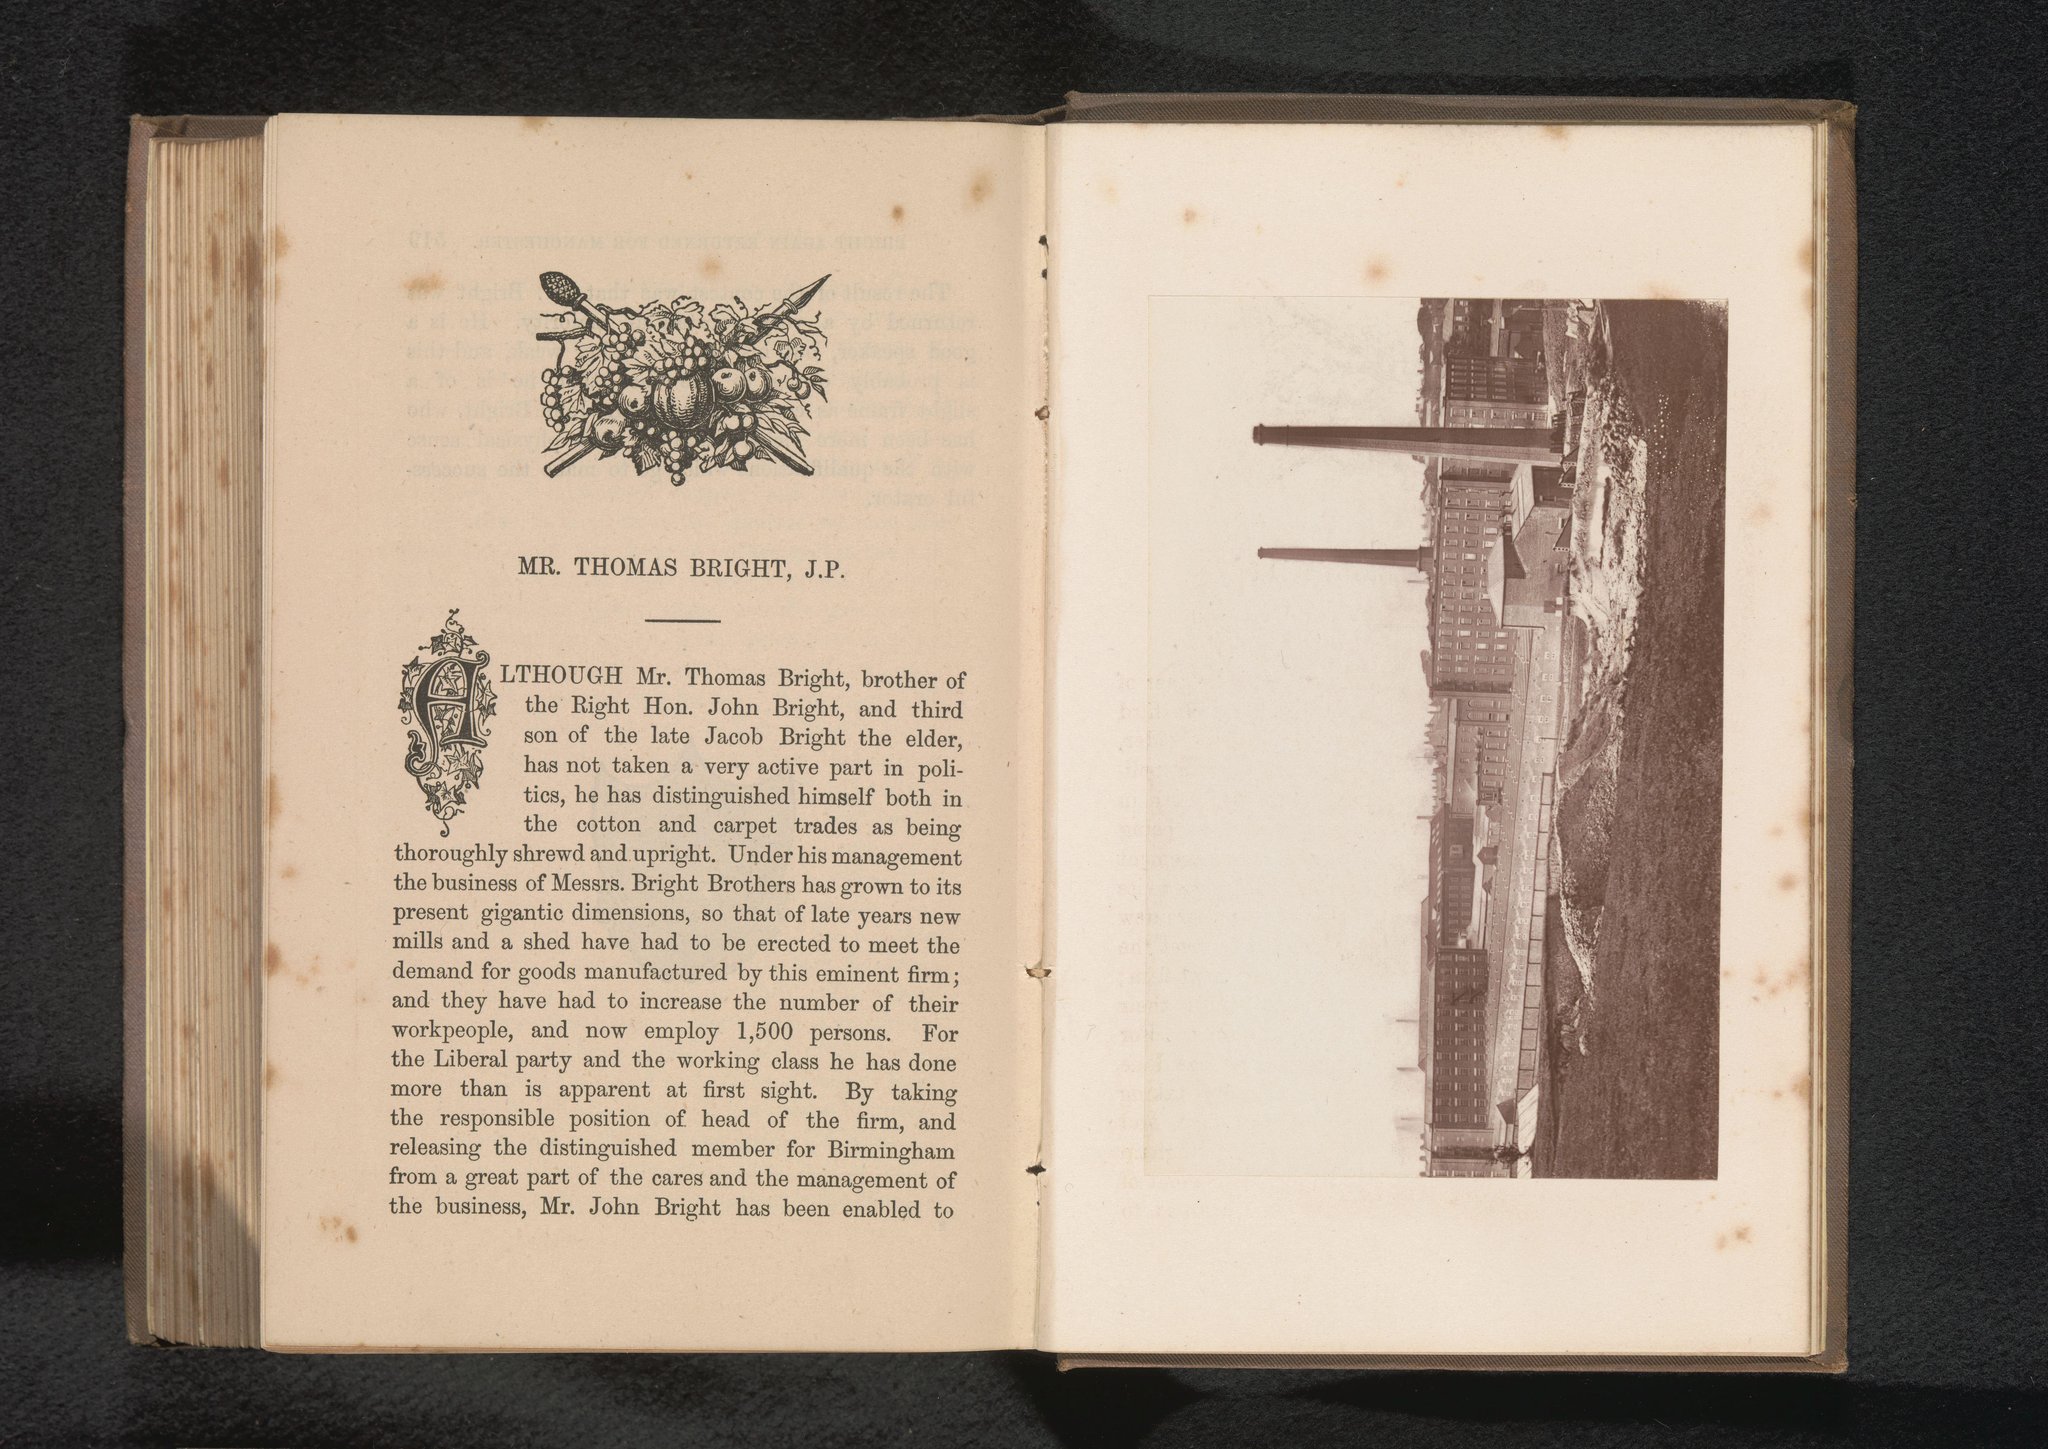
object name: page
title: Gezicht op de Fieldhouse Mills te Rochdale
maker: Anonymous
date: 1873-1878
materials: paper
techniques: woodburytype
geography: rochdale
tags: factories and mills in landscape, façade (of house or building)